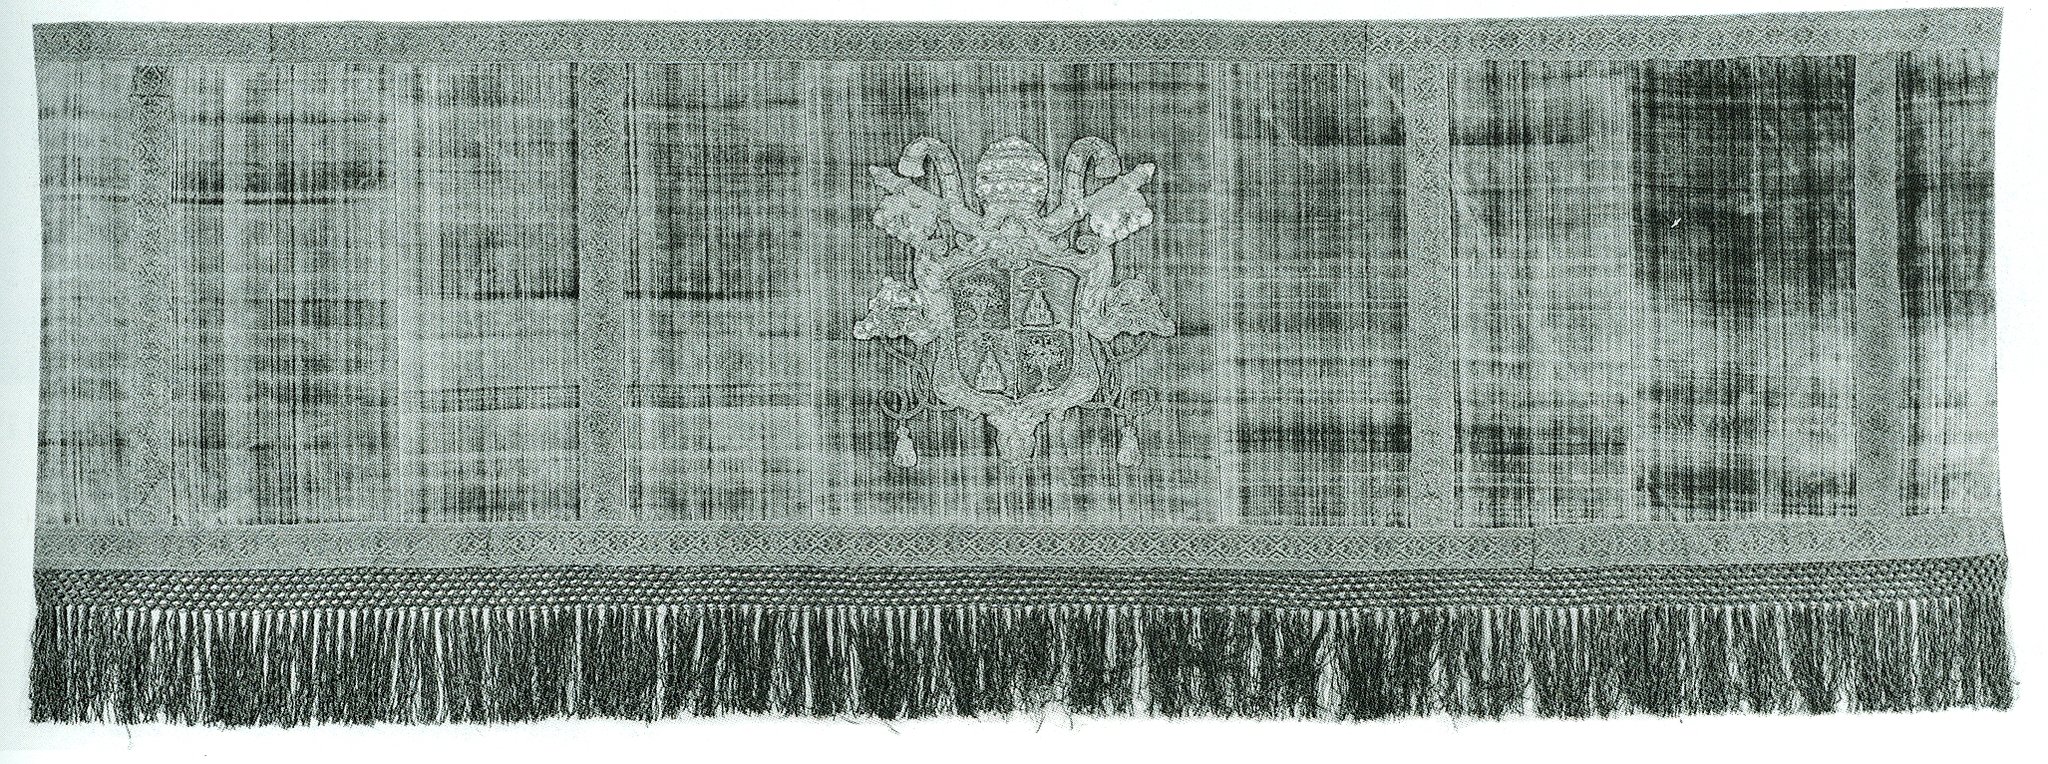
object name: valance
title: Valance with Chigi coat of arms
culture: italian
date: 1634-1666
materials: cotton, gilt, linen, silk, velvet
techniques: cutting, weave